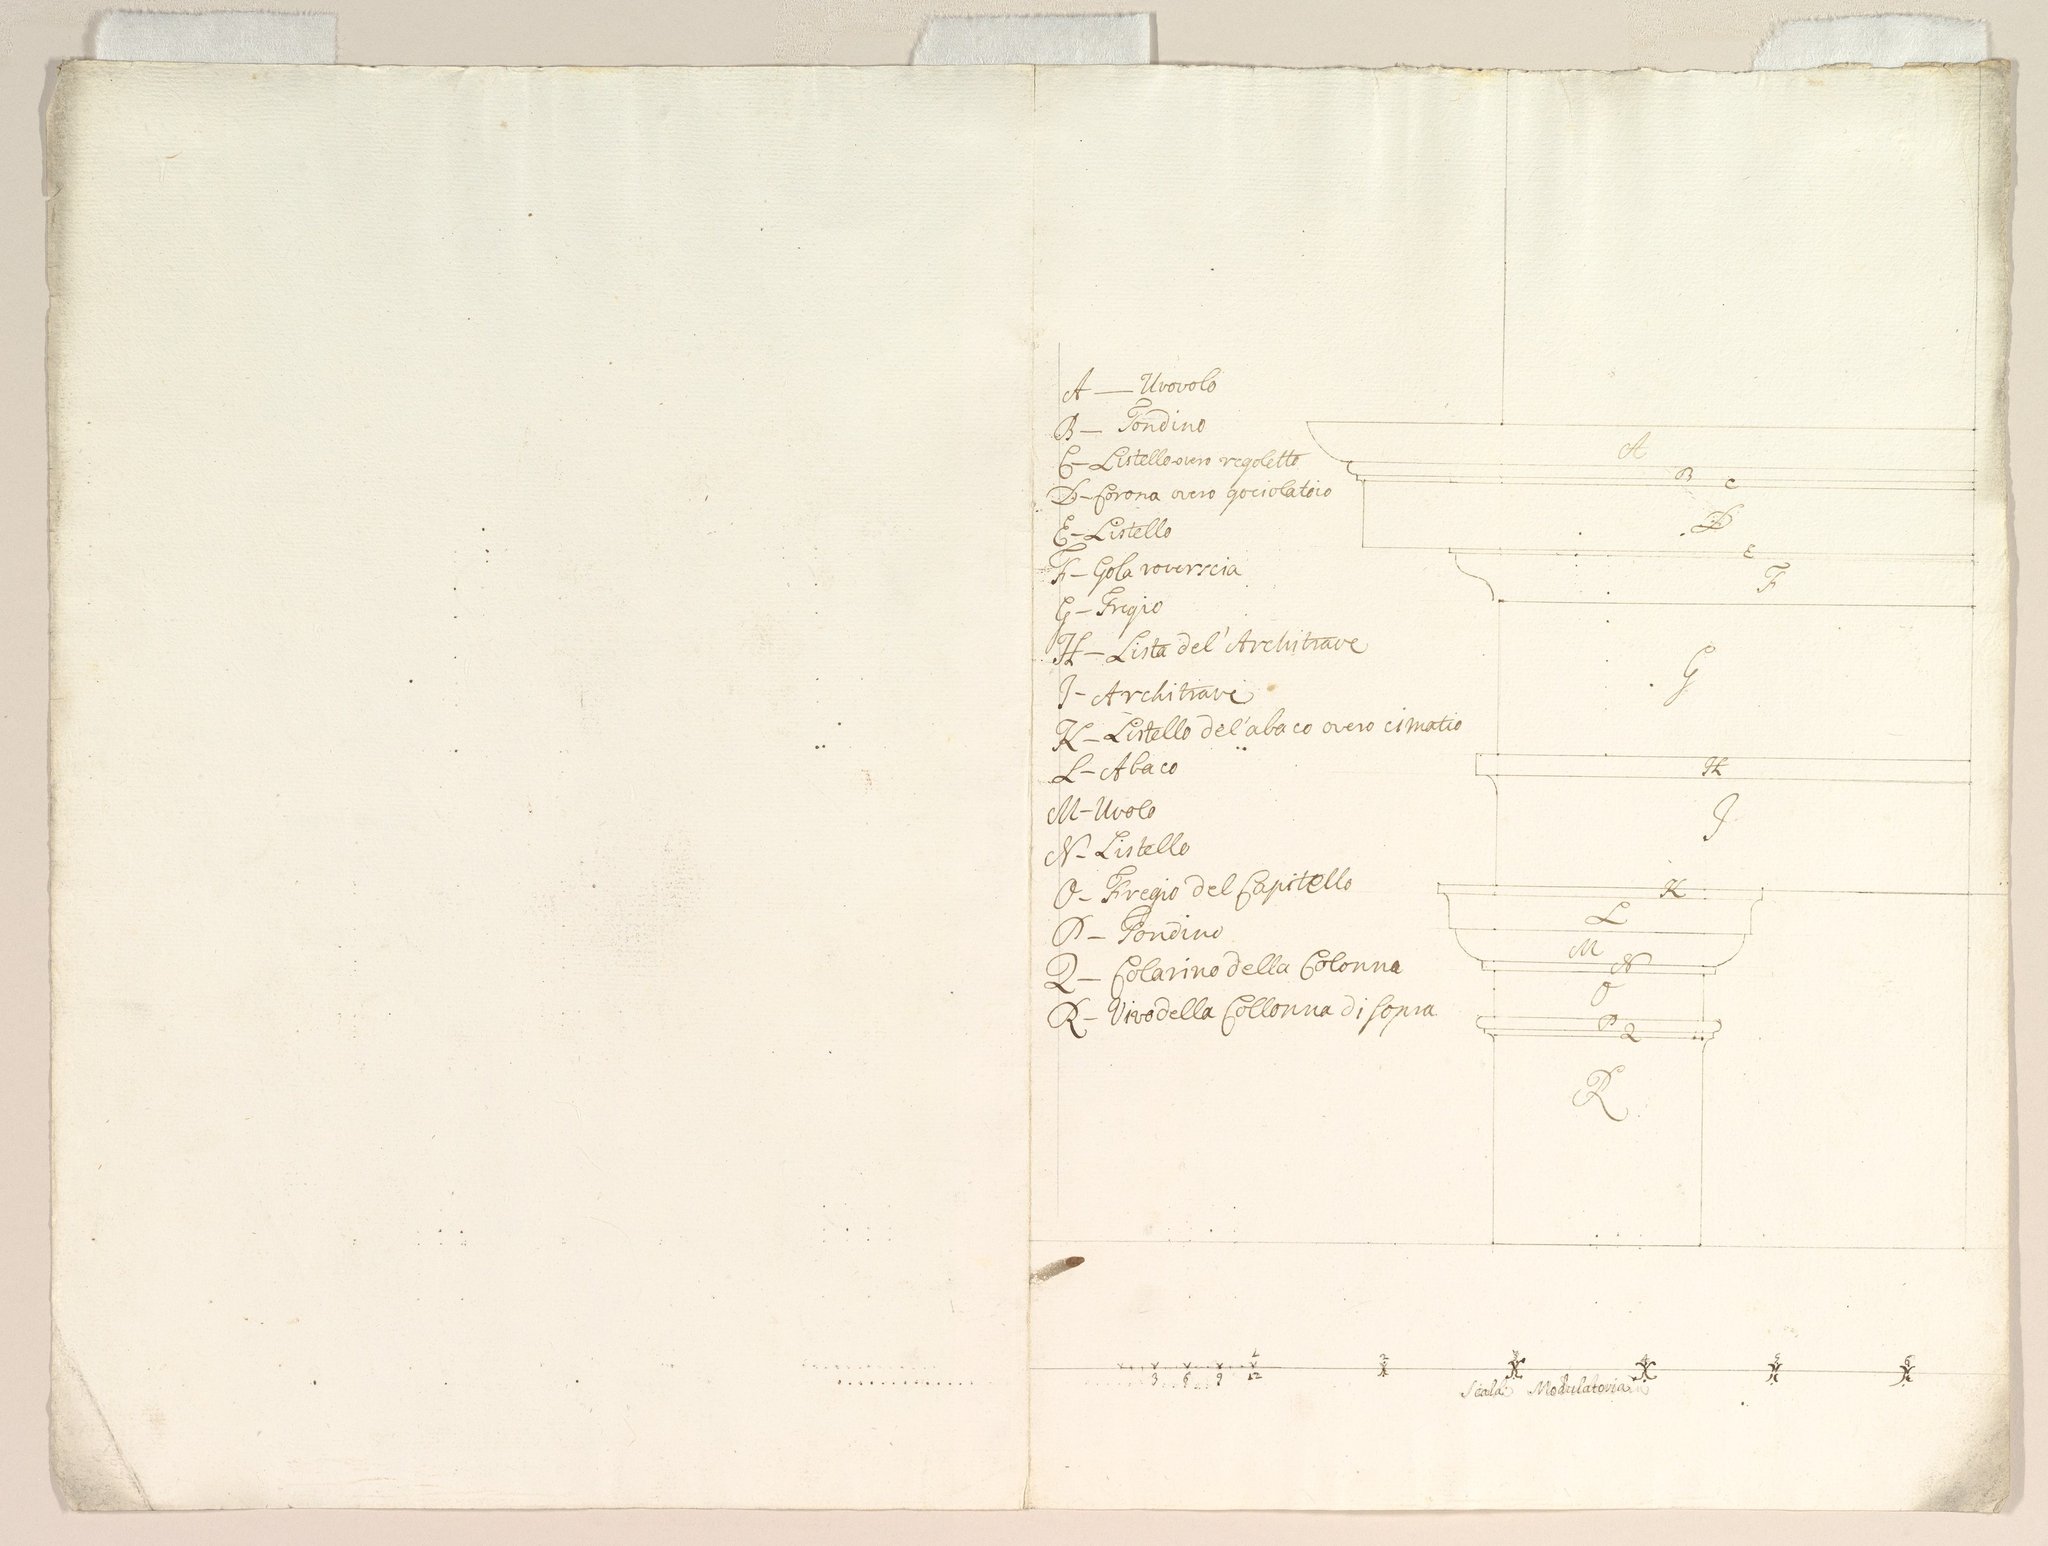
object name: drawing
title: Blown-up Detail of Design in Elevation for Colonnade in the Doric or Tuscan Order (recto); Blown-up Detail of Column on Podium in Elevation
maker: anonymous, italian, piedmontese, 18th century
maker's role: artist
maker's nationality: italian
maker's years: 1700-1800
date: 1701-1800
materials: ink, drawing material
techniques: pen